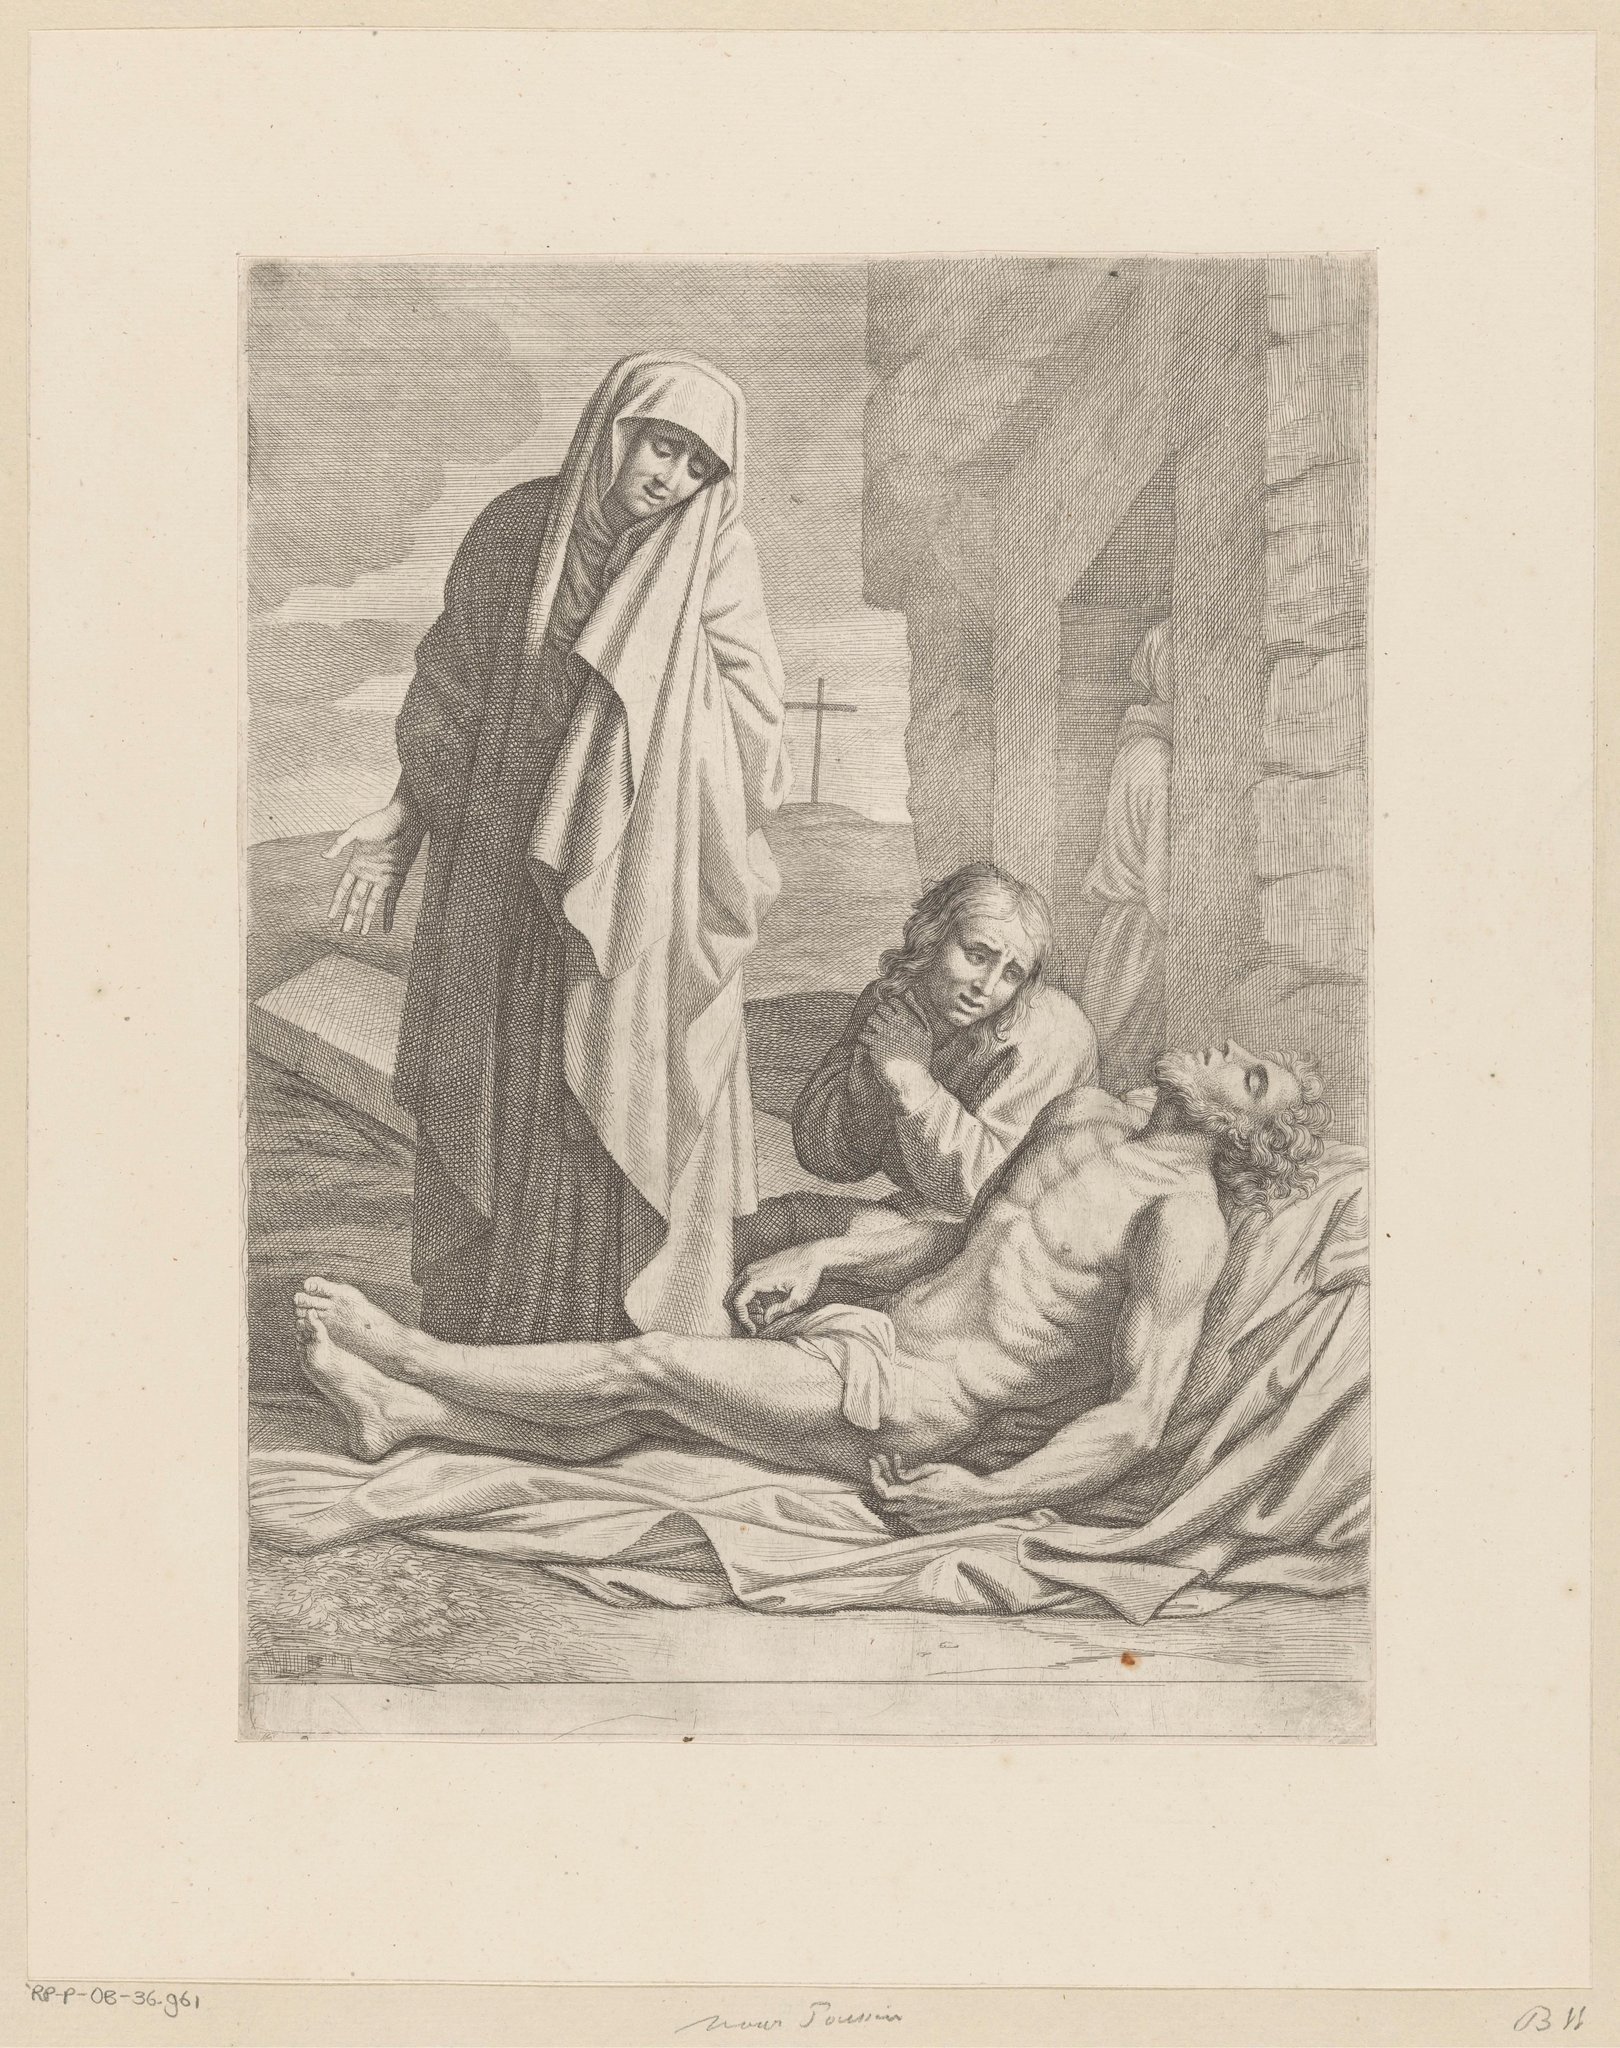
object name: print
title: Bewening van Maria en Johannes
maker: pietro del po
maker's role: print maker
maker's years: 1610-1692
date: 1620-1692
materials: paper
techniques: etching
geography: italy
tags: lamentation over the dead christ by his relatives and friends (christ usually without crown of thorns)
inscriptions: collector's mark: Lugt 240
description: Maria en Johannes de Evangelist treuren bij het lichaam van Christus. Op de achtergrond het kruis op de berg Golgota.